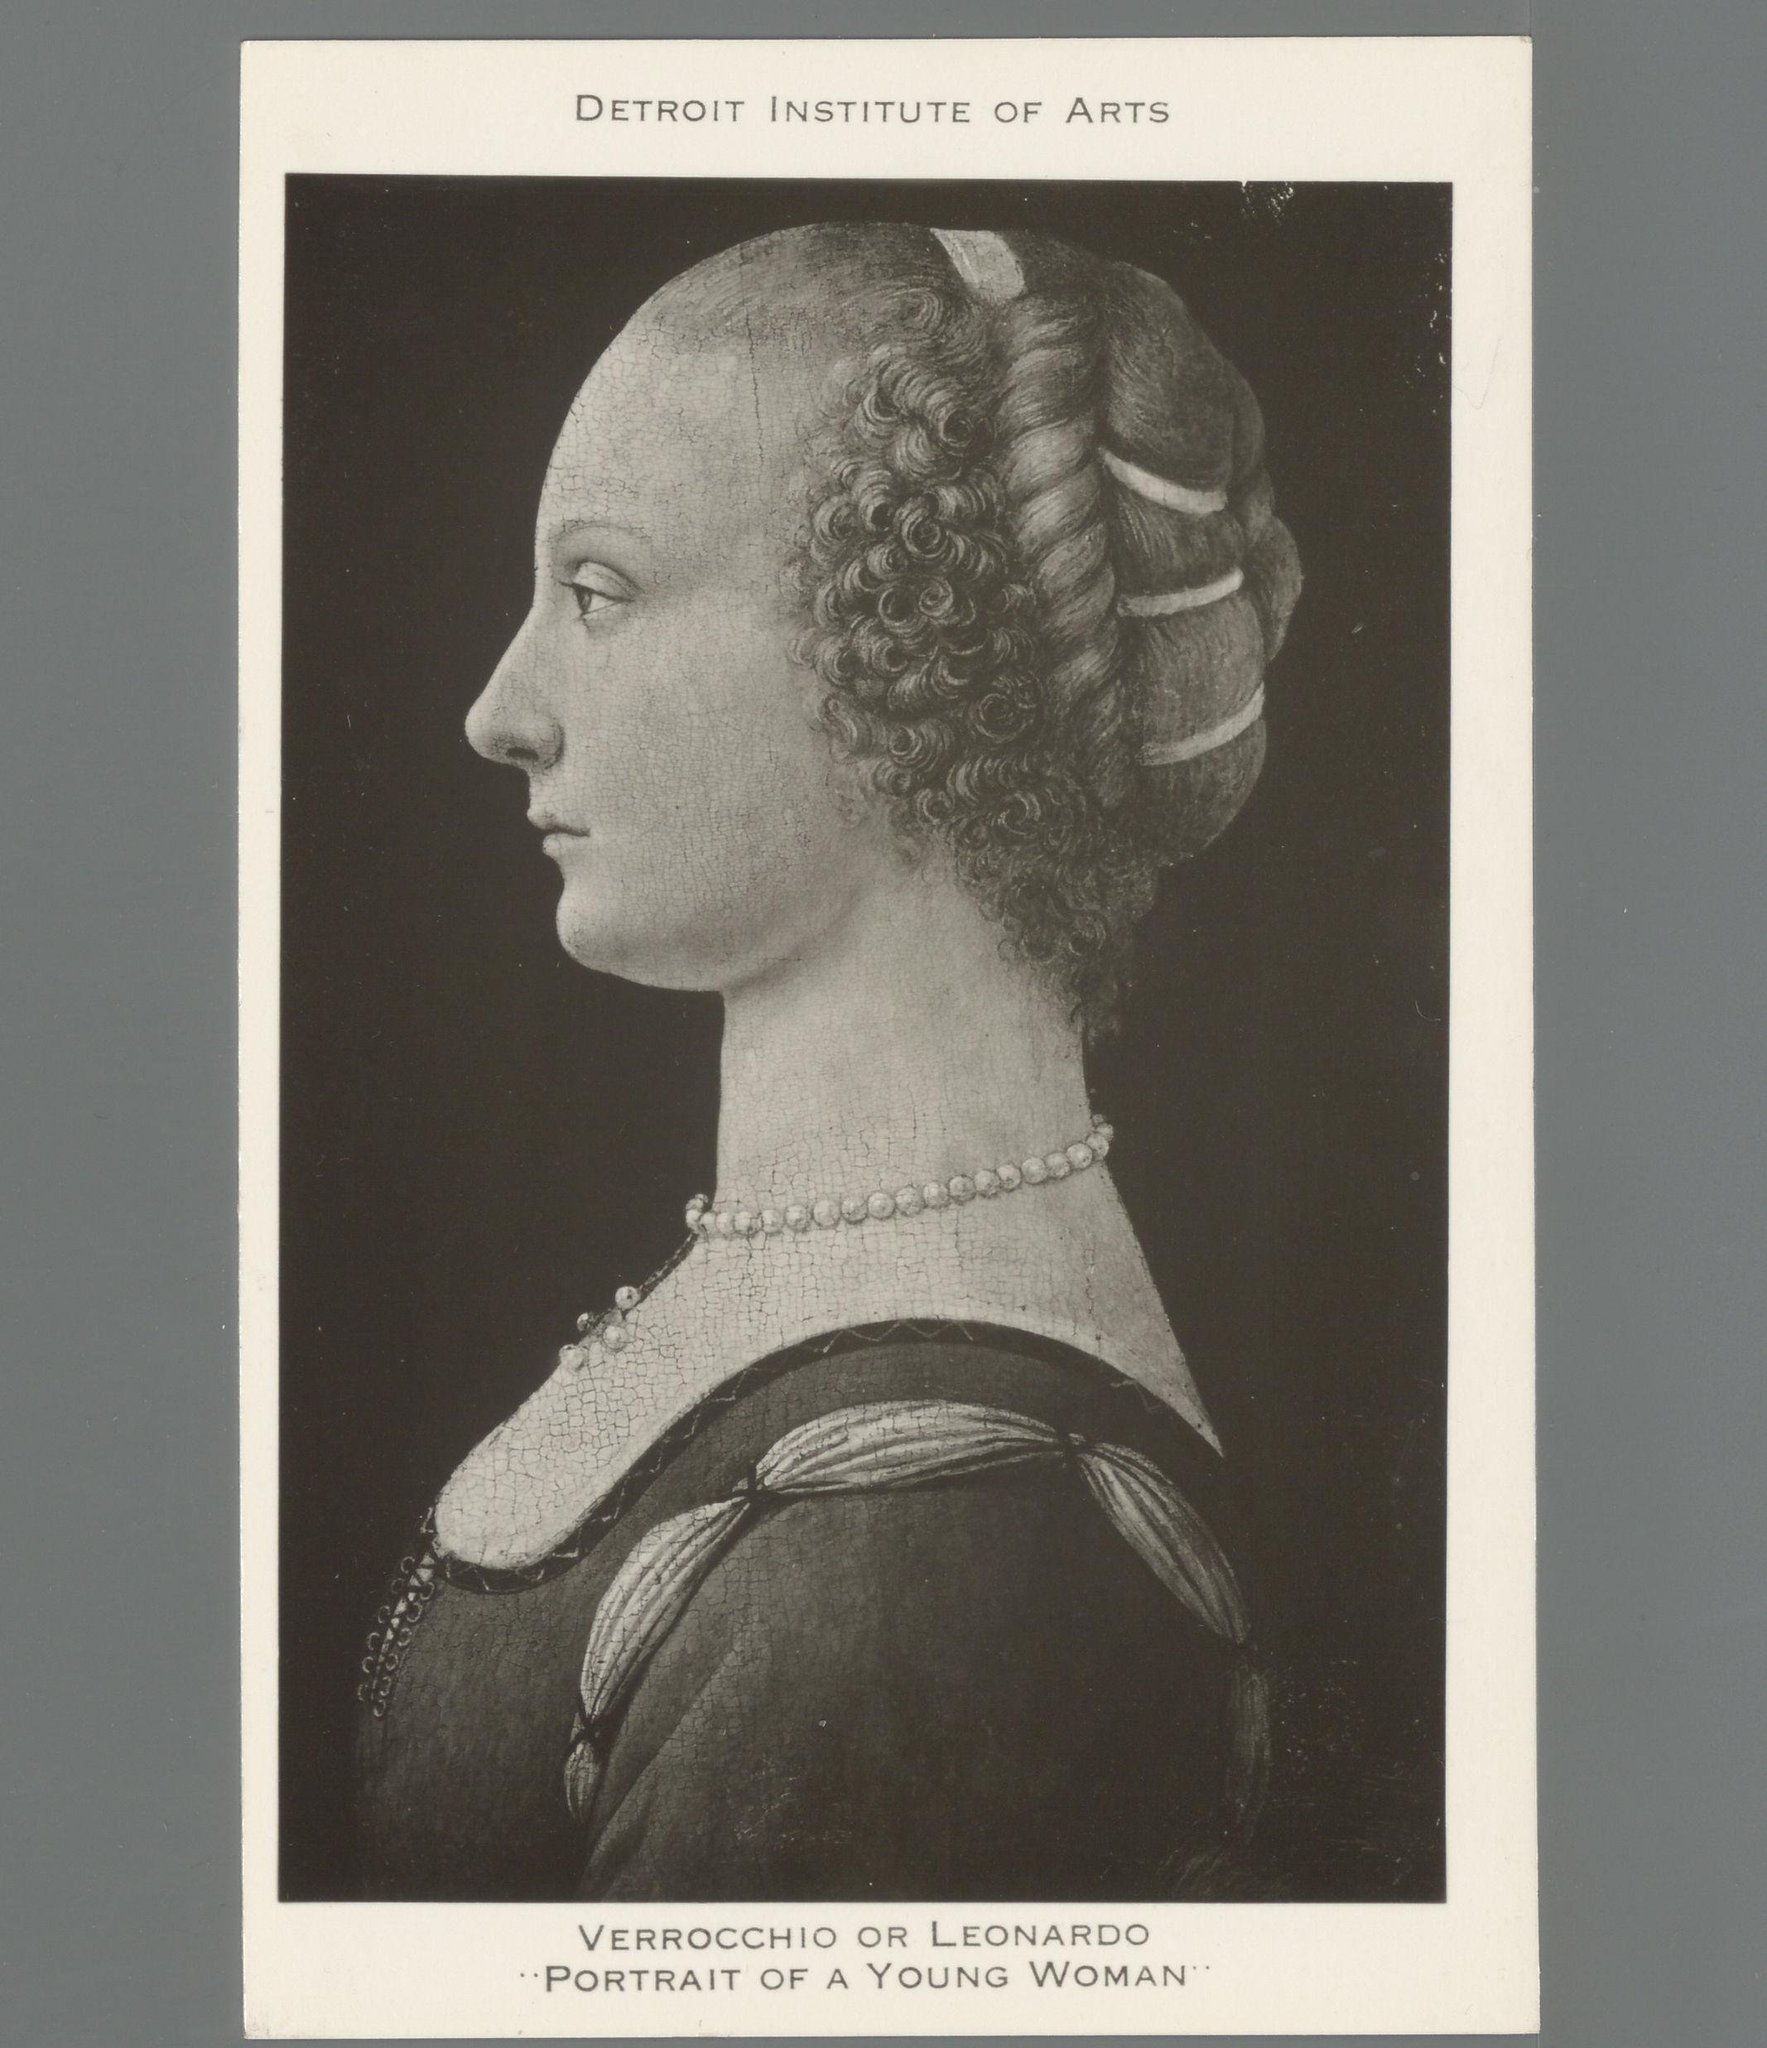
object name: ansichtkaart, prentbriefkaart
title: Portrait of a young woman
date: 1936-1945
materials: photographic support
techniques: photography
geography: detroit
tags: adult woman (+ sideview, profile), historical persons not known by name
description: Het Detroit Institute of Arts schrijft het schilderij inmiddels toe aan het "atelier van Domenico Ghirlandaio". Op de kaart staan Verrocchio of Leonardo als mogelijke schilders.